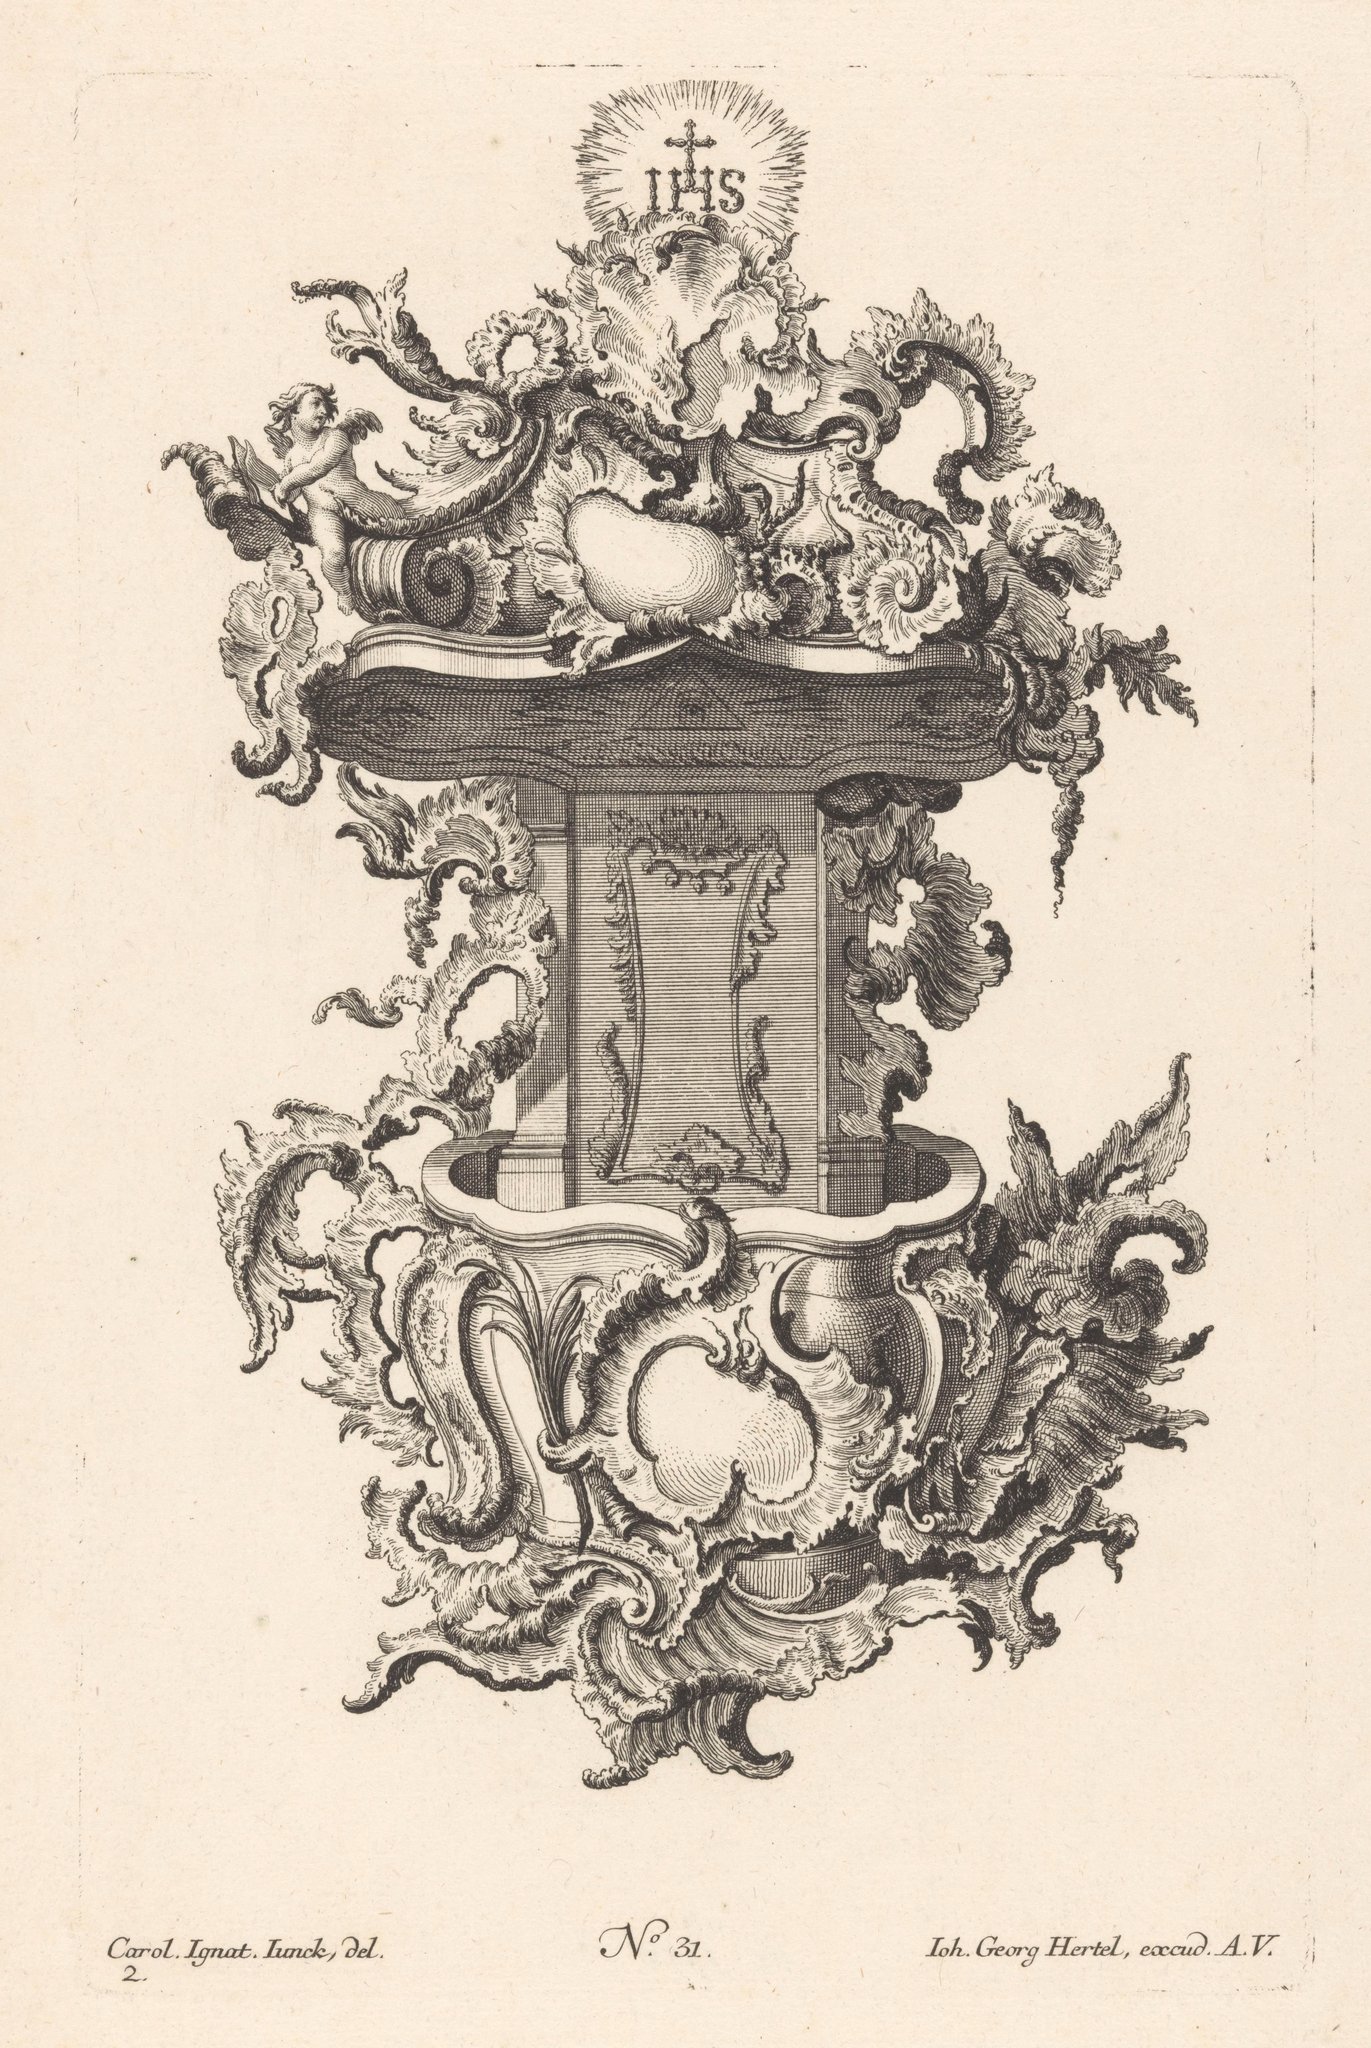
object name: print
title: Preekstoelen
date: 1750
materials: paper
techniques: engraving, etching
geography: augsburg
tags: ihs ('iesus hominum salvator') ~ symbol of christ, pulpit, ambo, chancel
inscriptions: collector's mark: Lugt 2228, collector's mark: Lugt 2760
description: Ontwerp voor een preekstoel met rocaille ornamenten en cartouches. De bekroning is gedecoreerd met een gevleugelde putto en de letters IHS in stralenkrans. Uitgeversnummer 31.